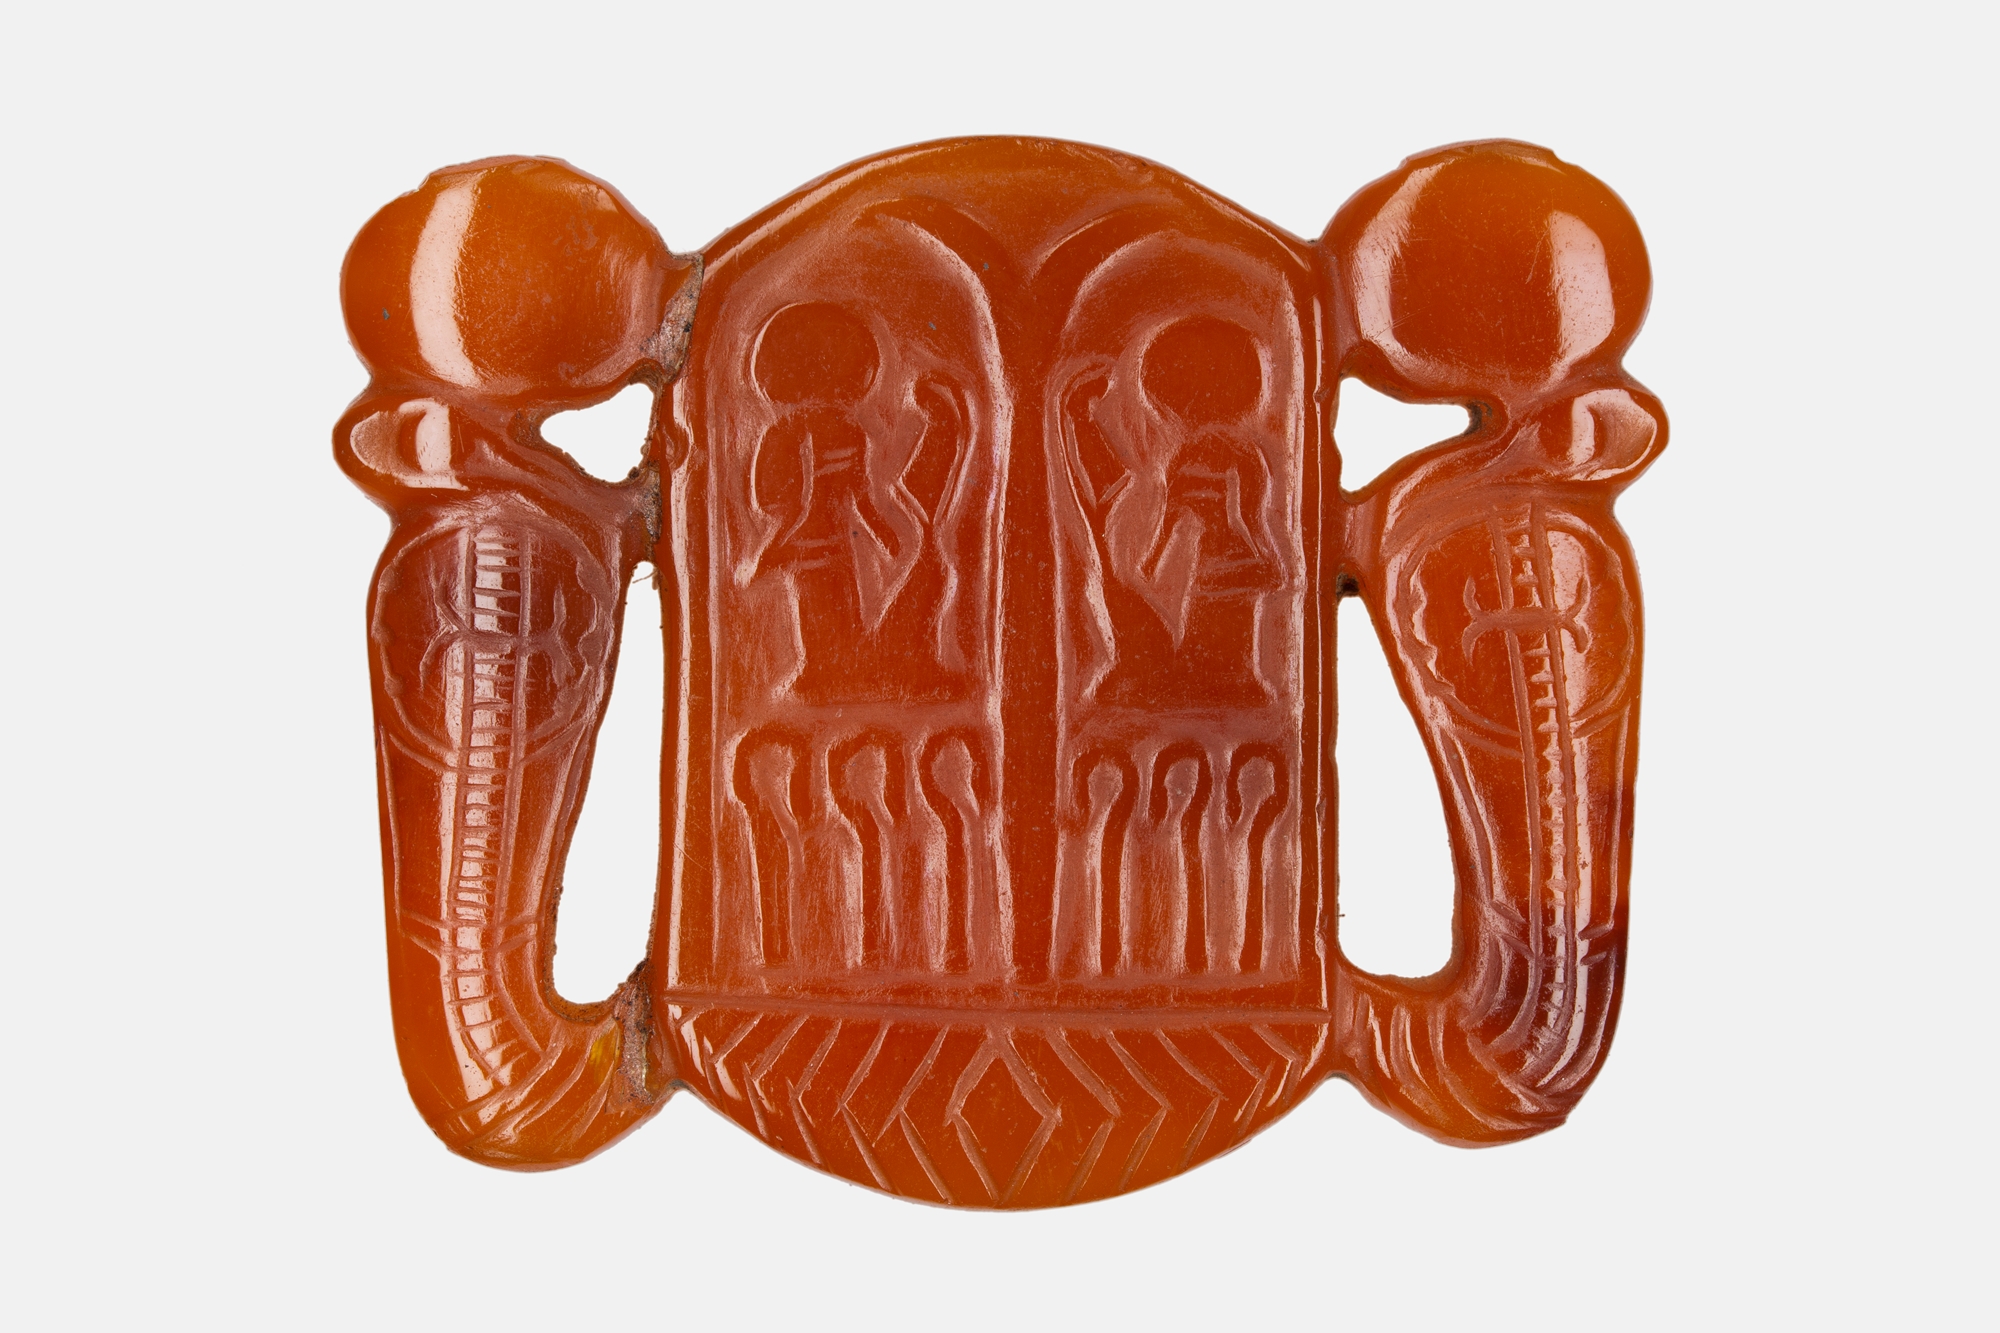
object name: plaque flanked by double uraeus, name of amenhotep iii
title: Plaque with the Name of Amenhotep III Flanked by Two Uraei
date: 1390-1352 BCE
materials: gemstone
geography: egypt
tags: hieroglyphs